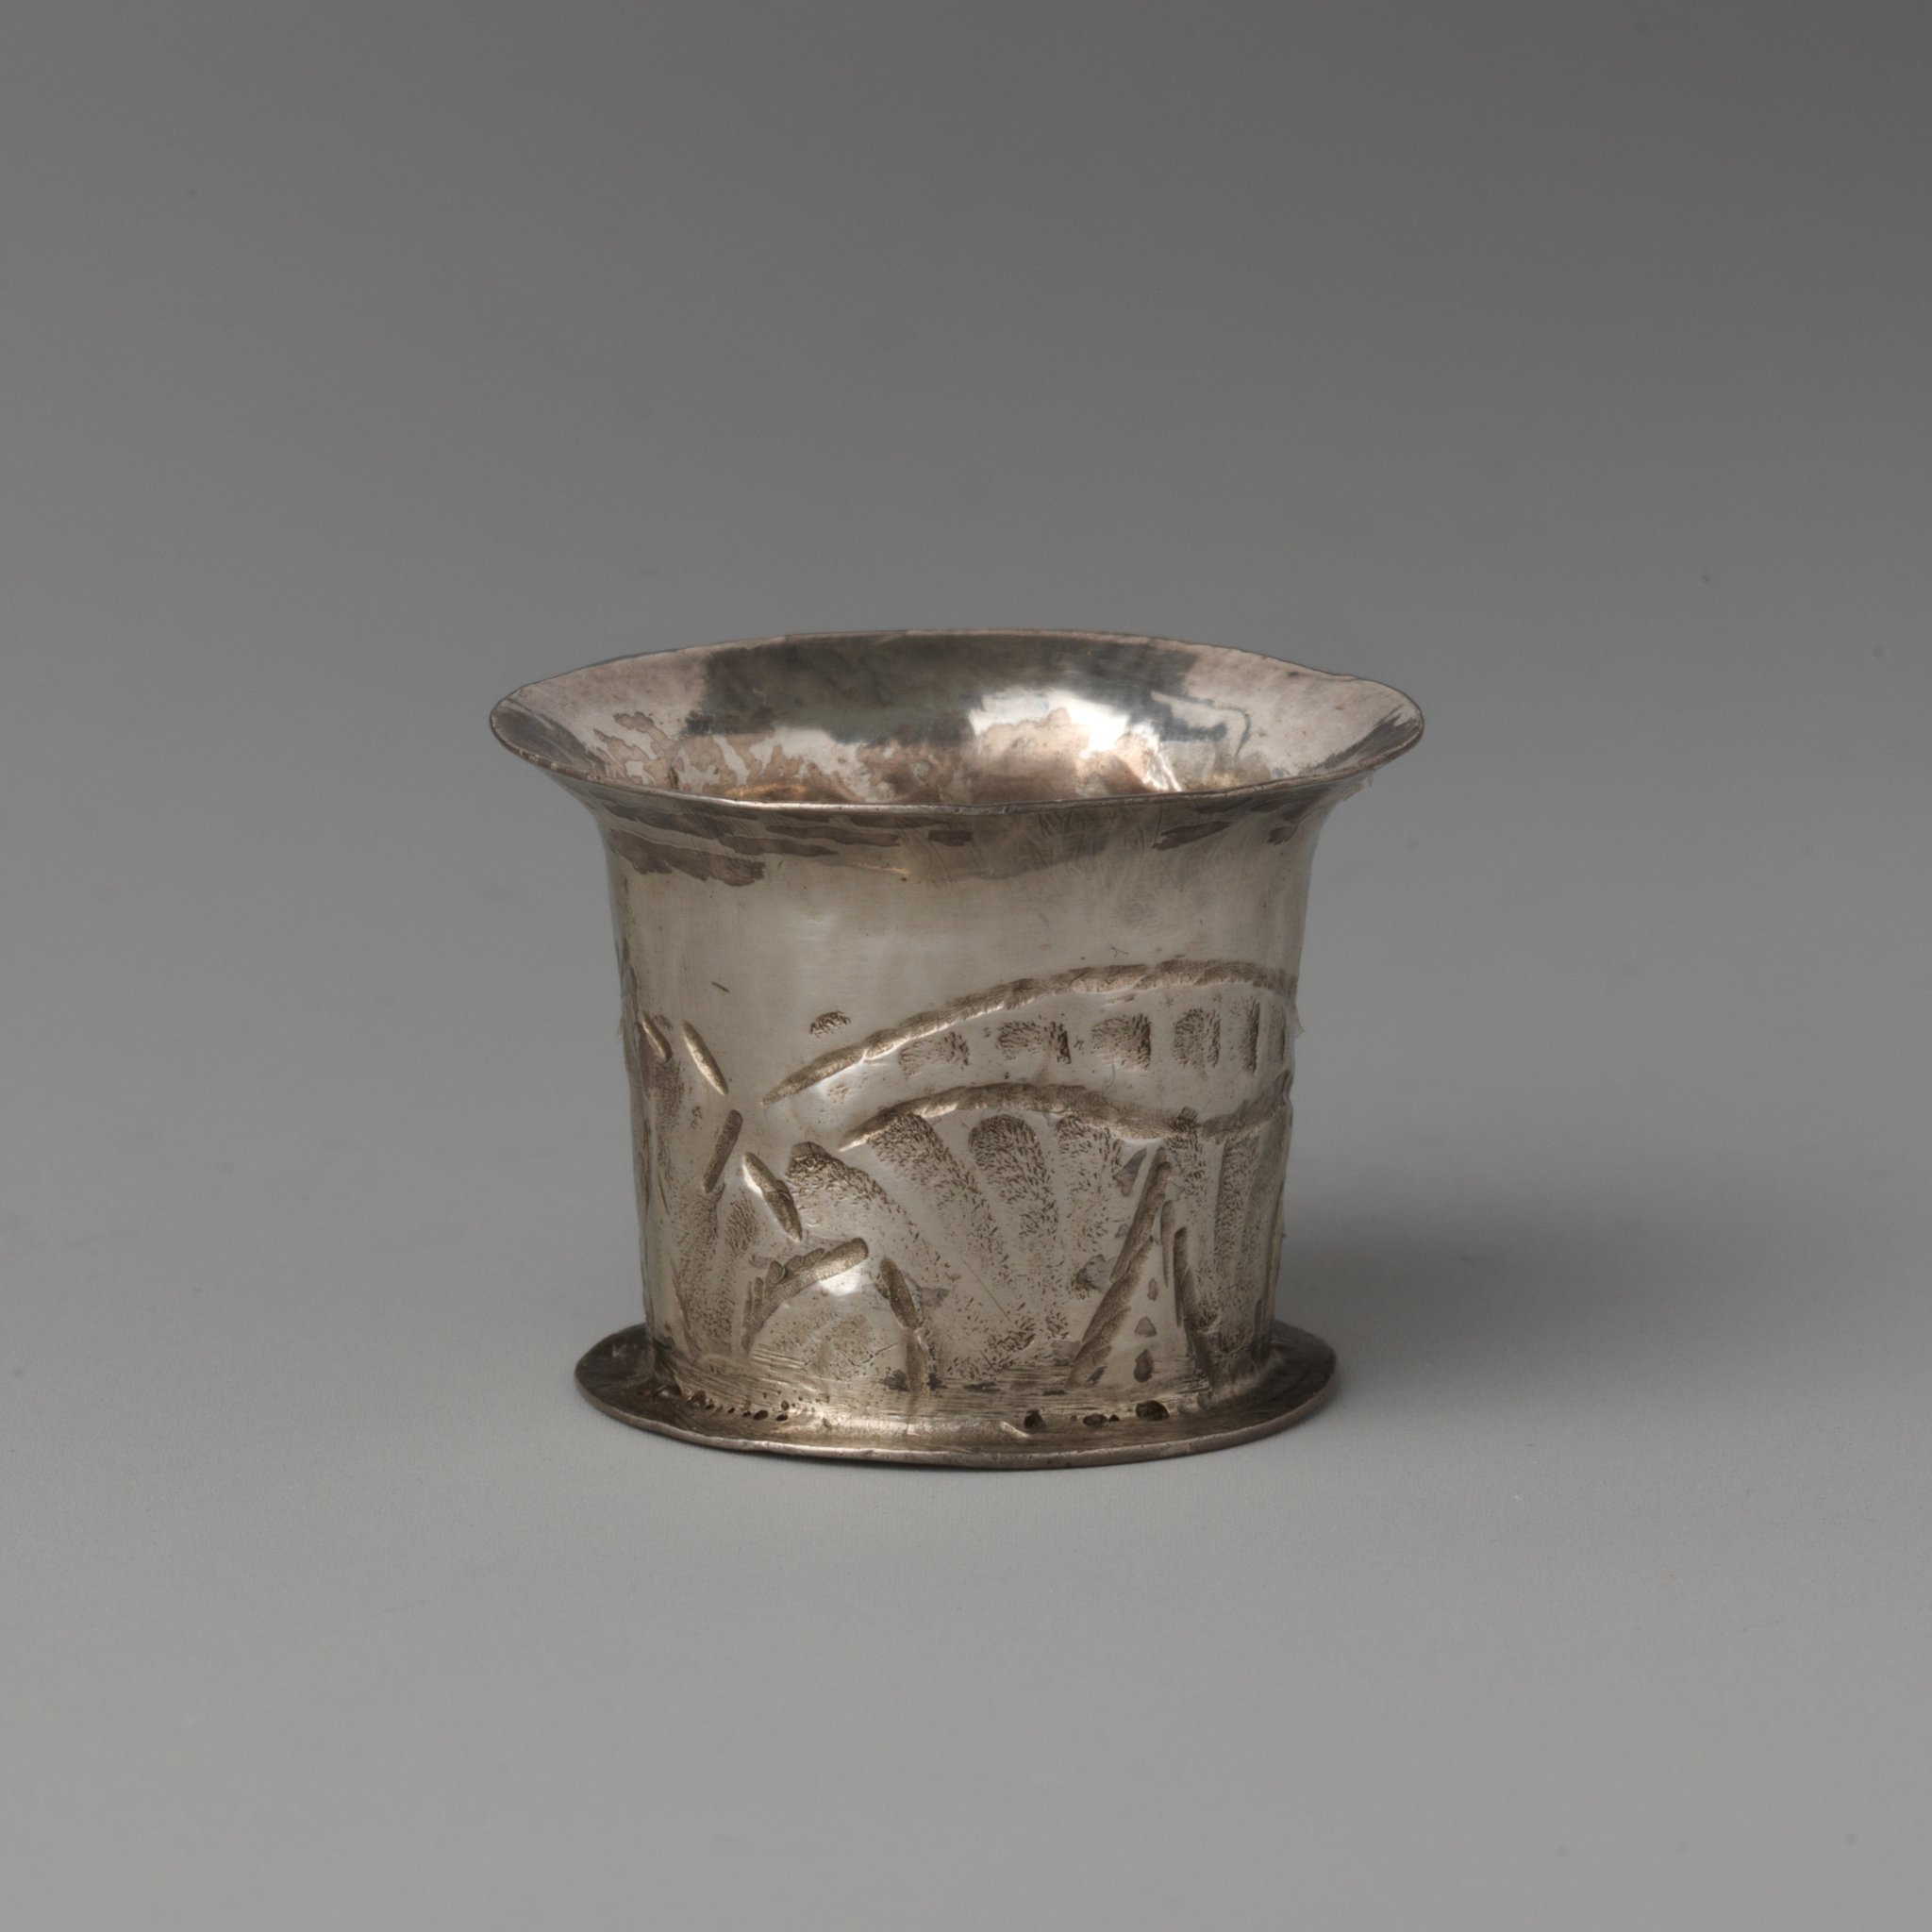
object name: beaker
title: Miniature beaker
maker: george manjoy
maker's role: maker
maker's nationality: british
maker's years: 1685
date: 1689-1690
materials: silver